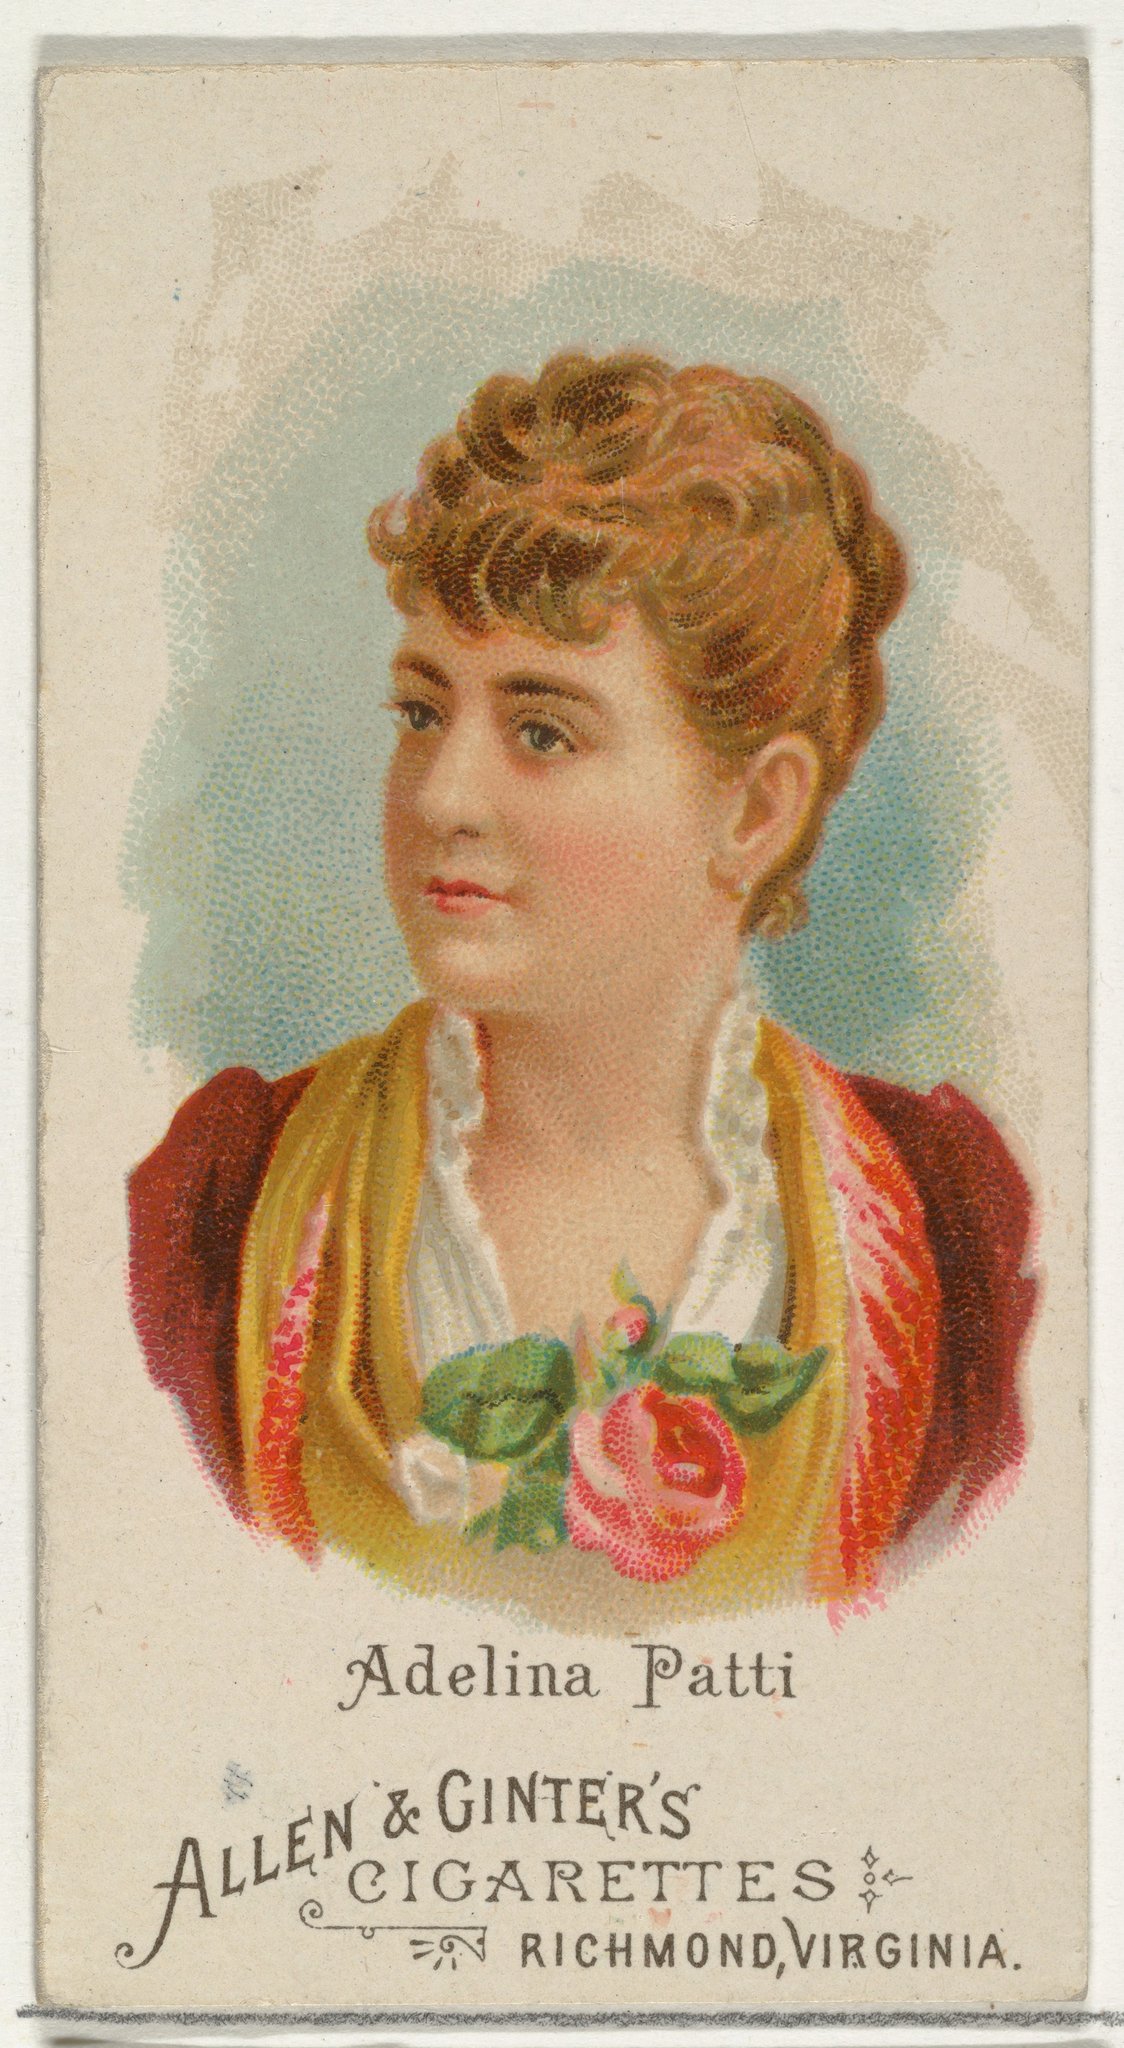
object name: print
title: Adelina Patti, from World's Beauties, Series 1 (N26) for Allen & Ginter Cigarettes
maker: allen & ginter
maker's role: publisher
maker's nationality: american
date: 1888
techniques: color lithograph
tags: women